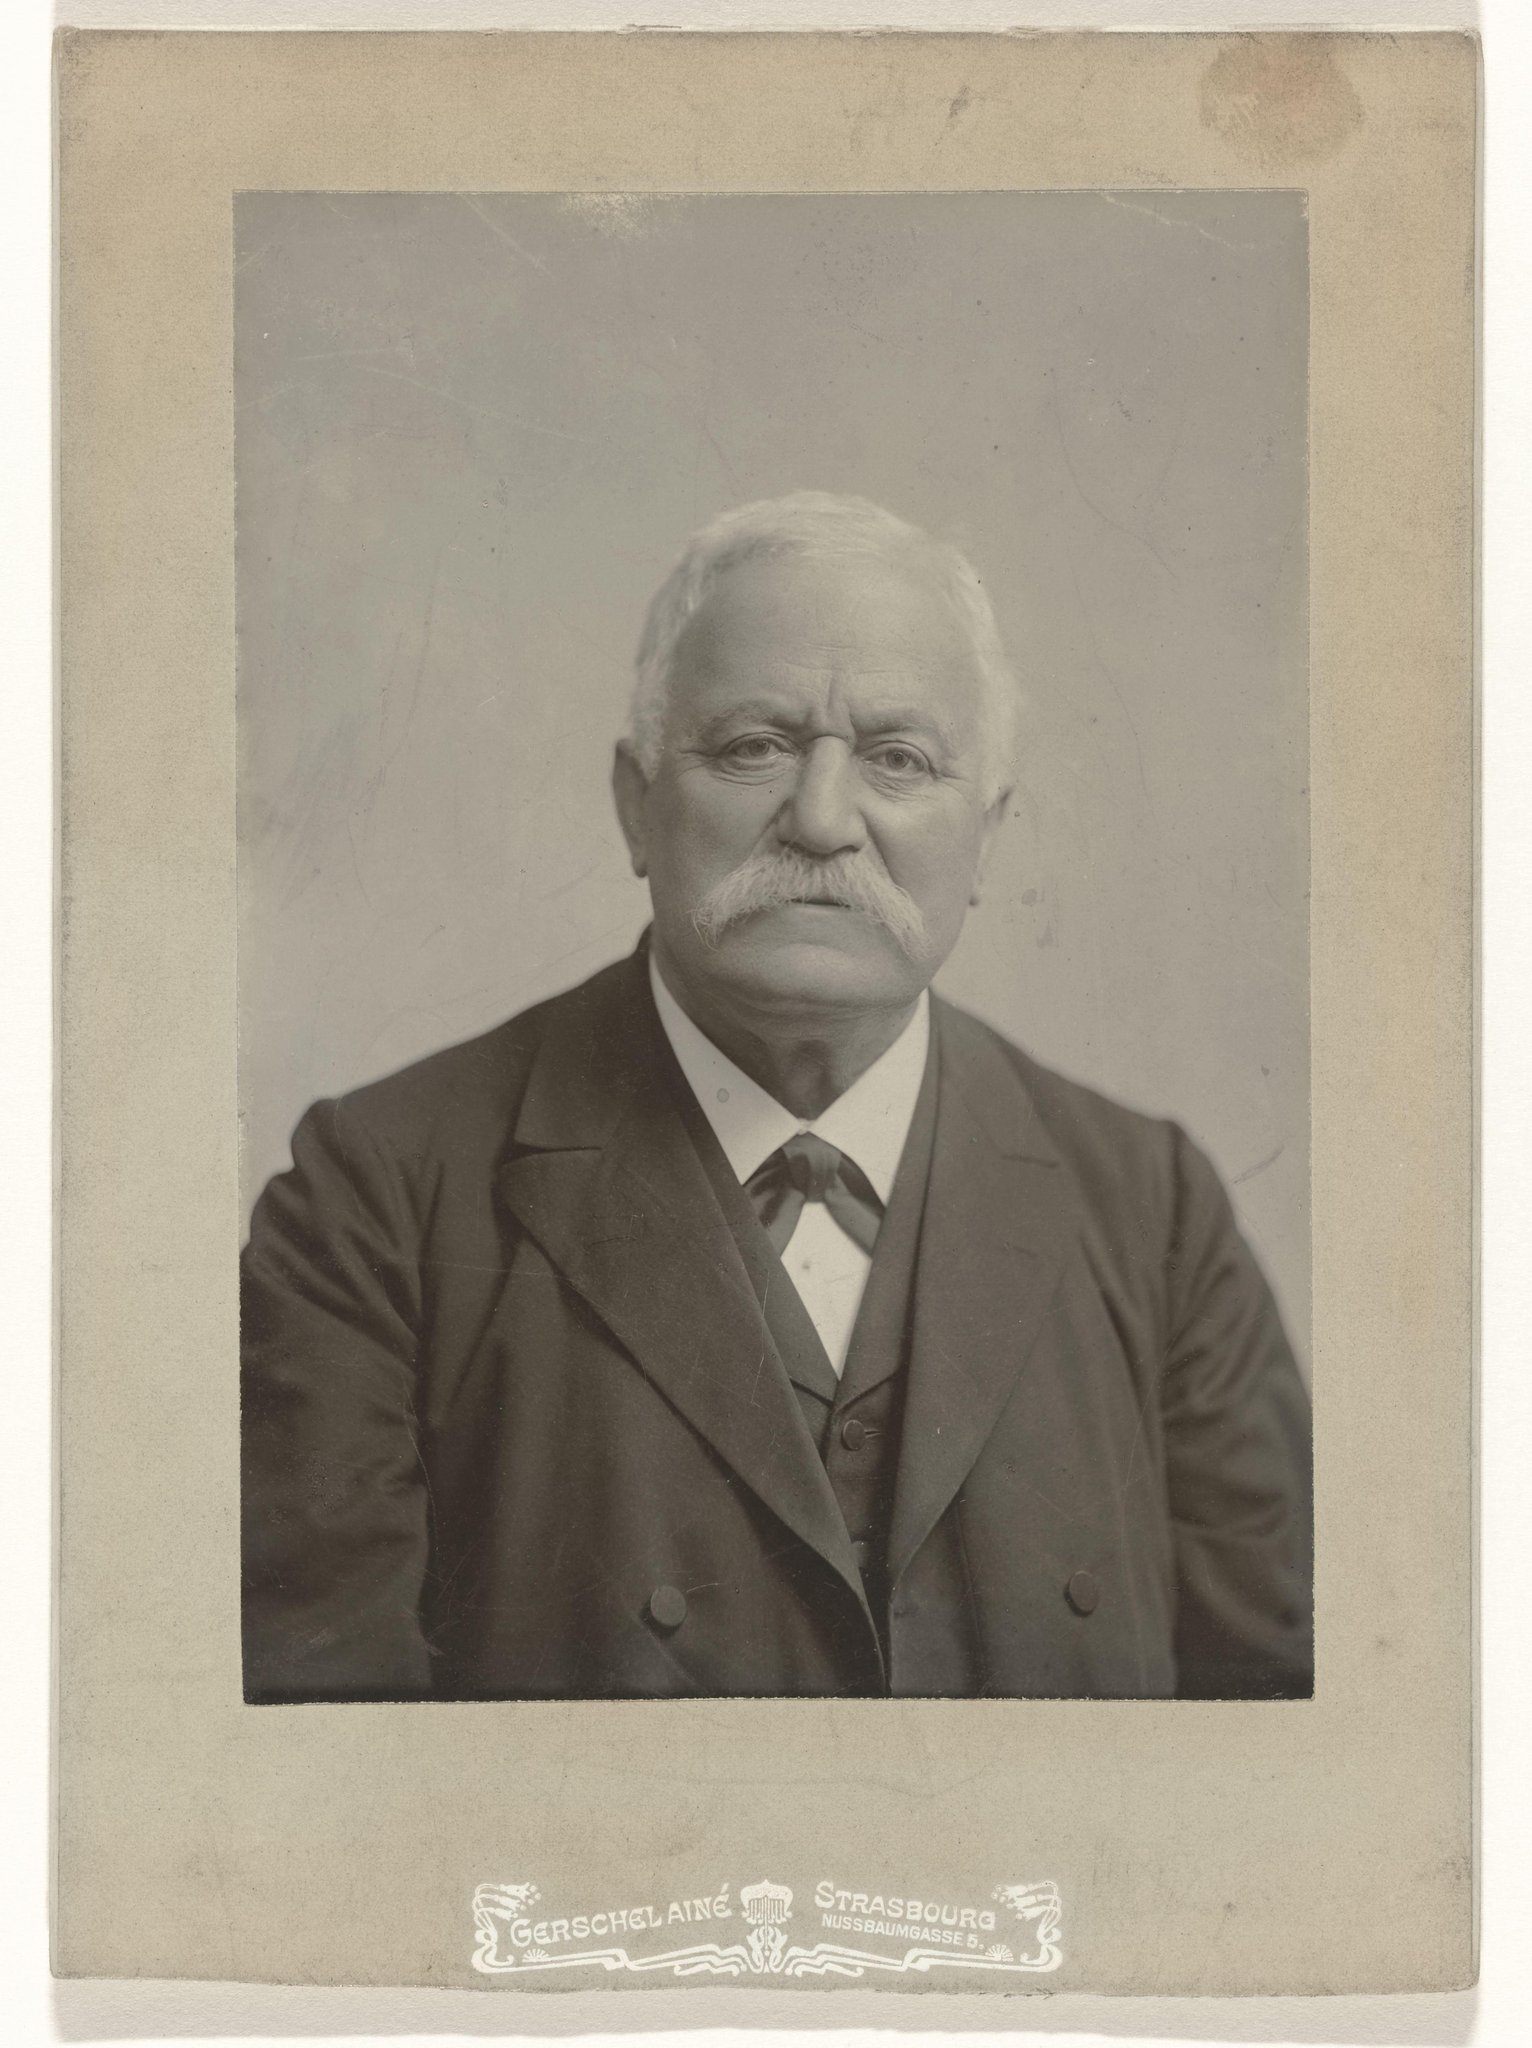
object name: photograph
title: Portret van oudere man met snor, in donkere kleding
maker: gerschel aîné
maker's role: fotograaf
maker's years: 1828-1898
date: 1890-1898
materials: photographic support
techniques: gelatin silver print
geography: straatsburg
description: Portret van oudere man met snor, in donkere kleding.